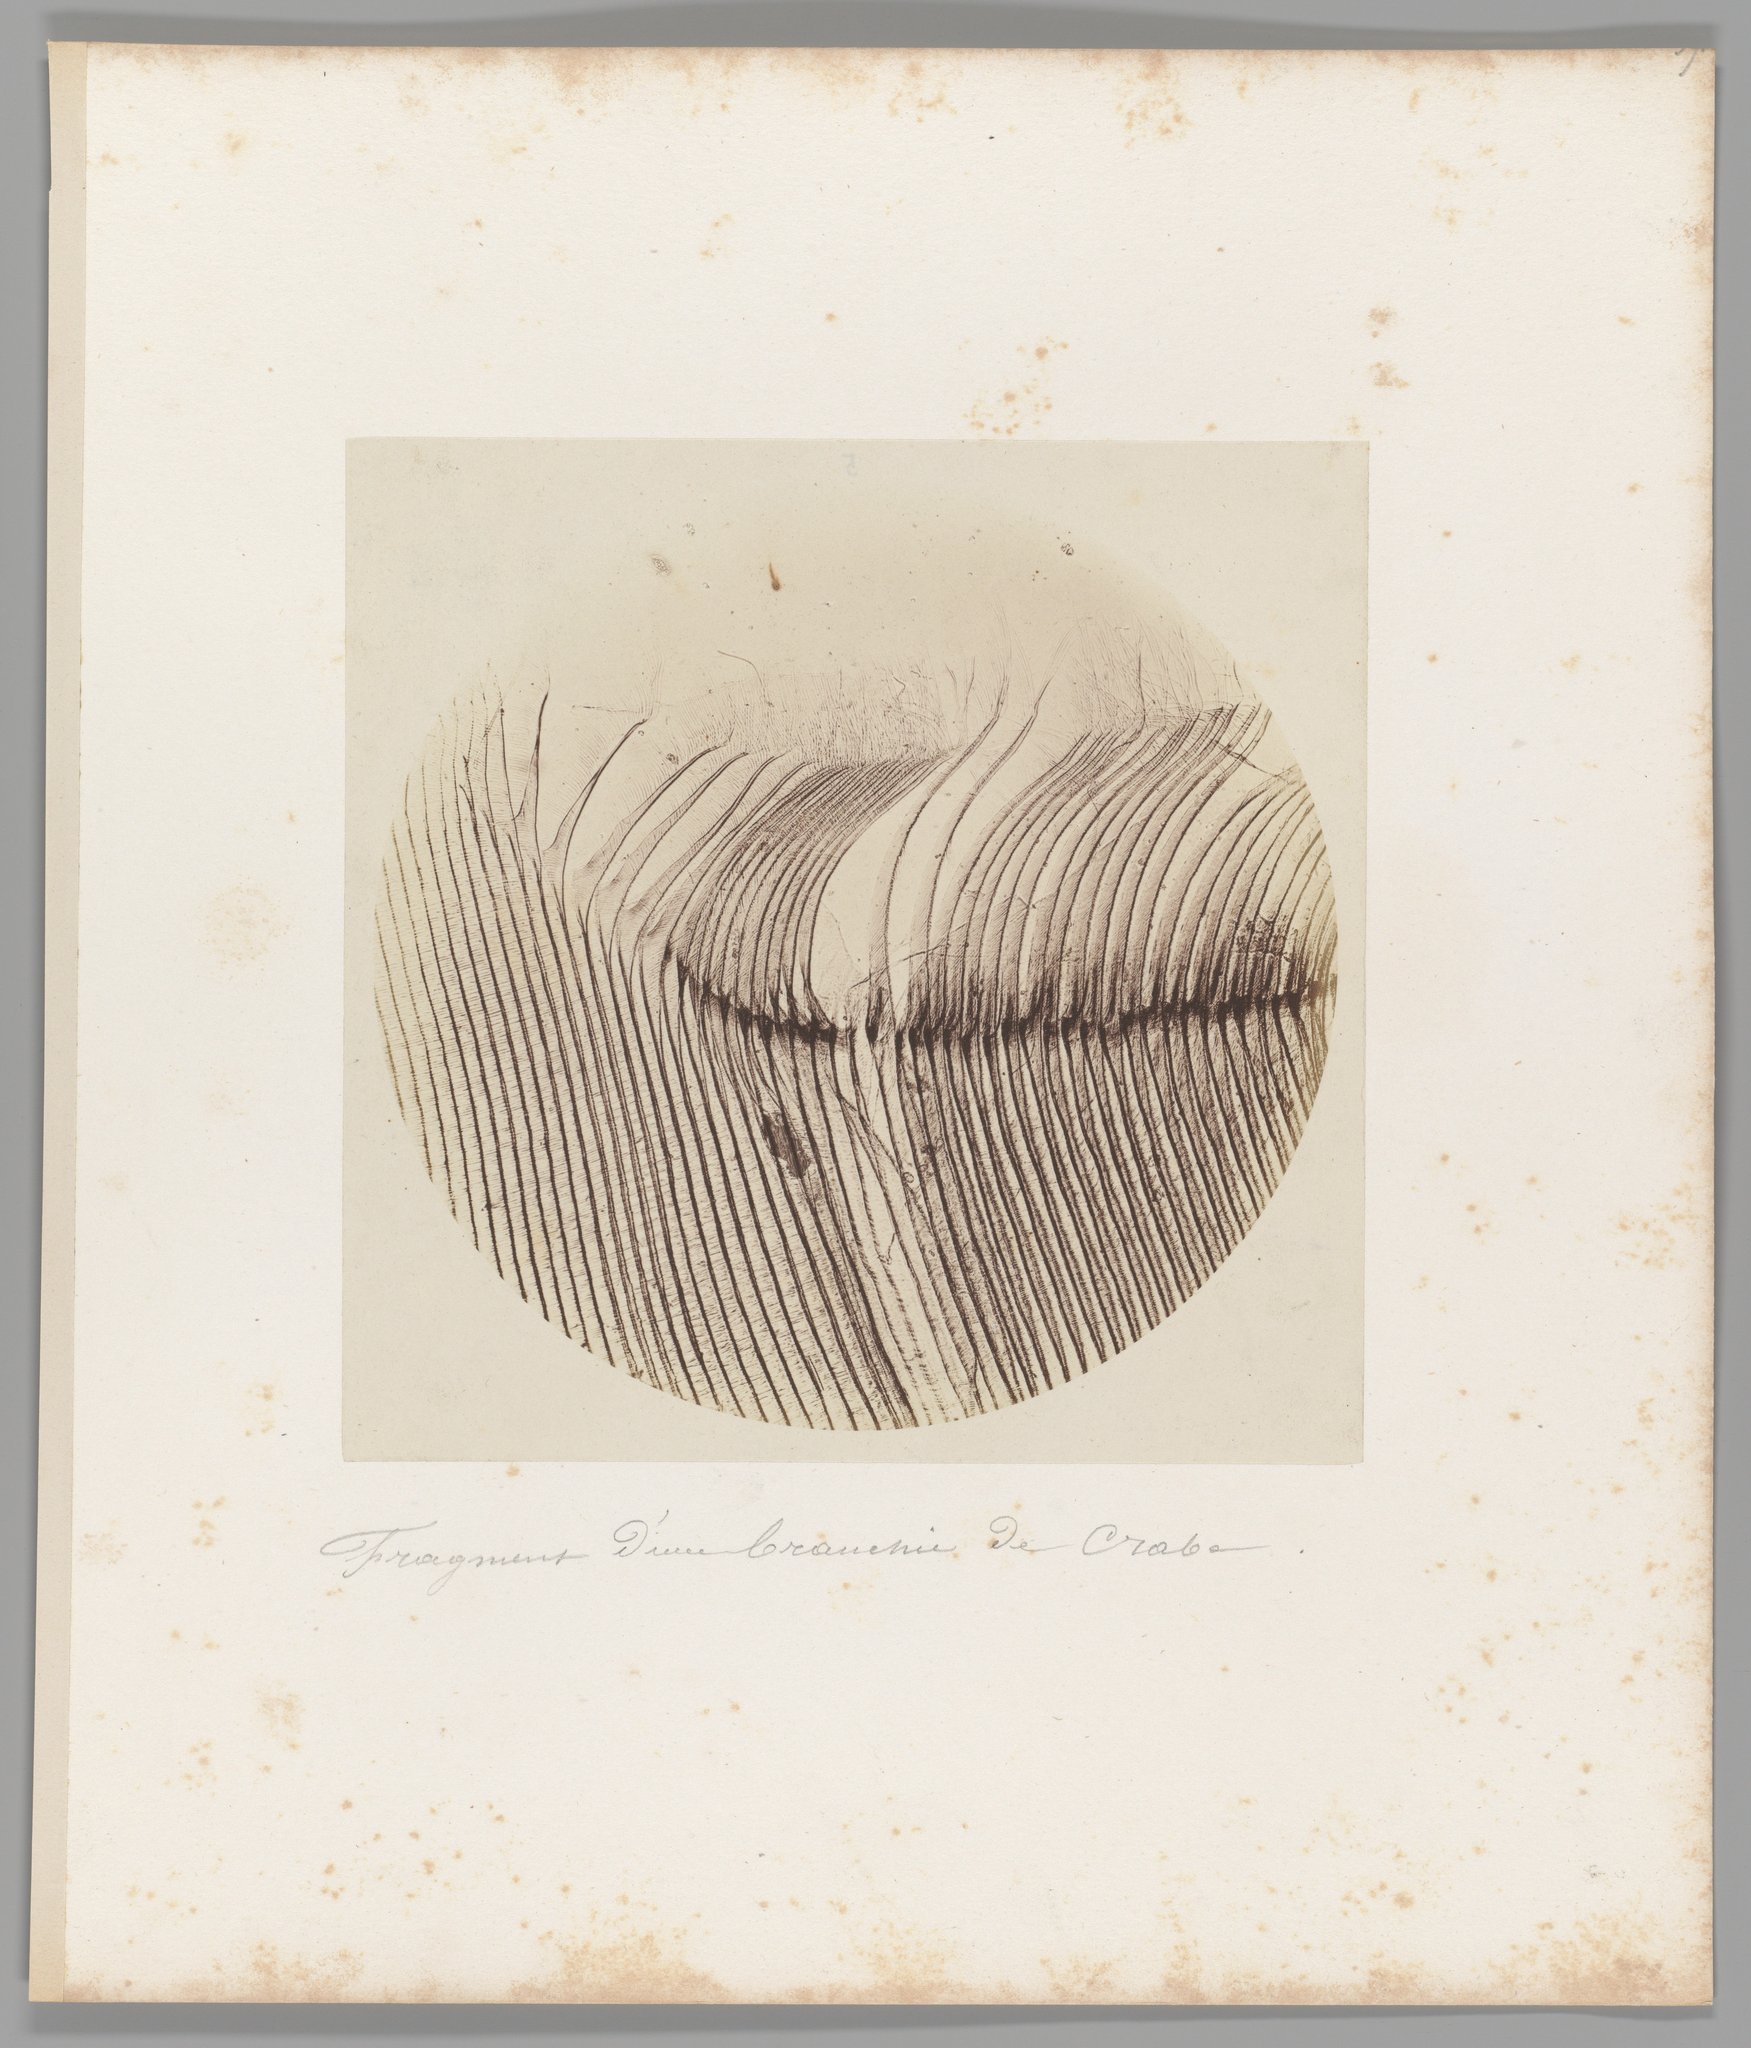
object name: photograph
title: [Untitled]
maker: auguste-adolphe bertsch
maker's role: artist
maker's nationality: french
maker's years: 1813-1871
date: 1853-1857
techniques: salted paper print